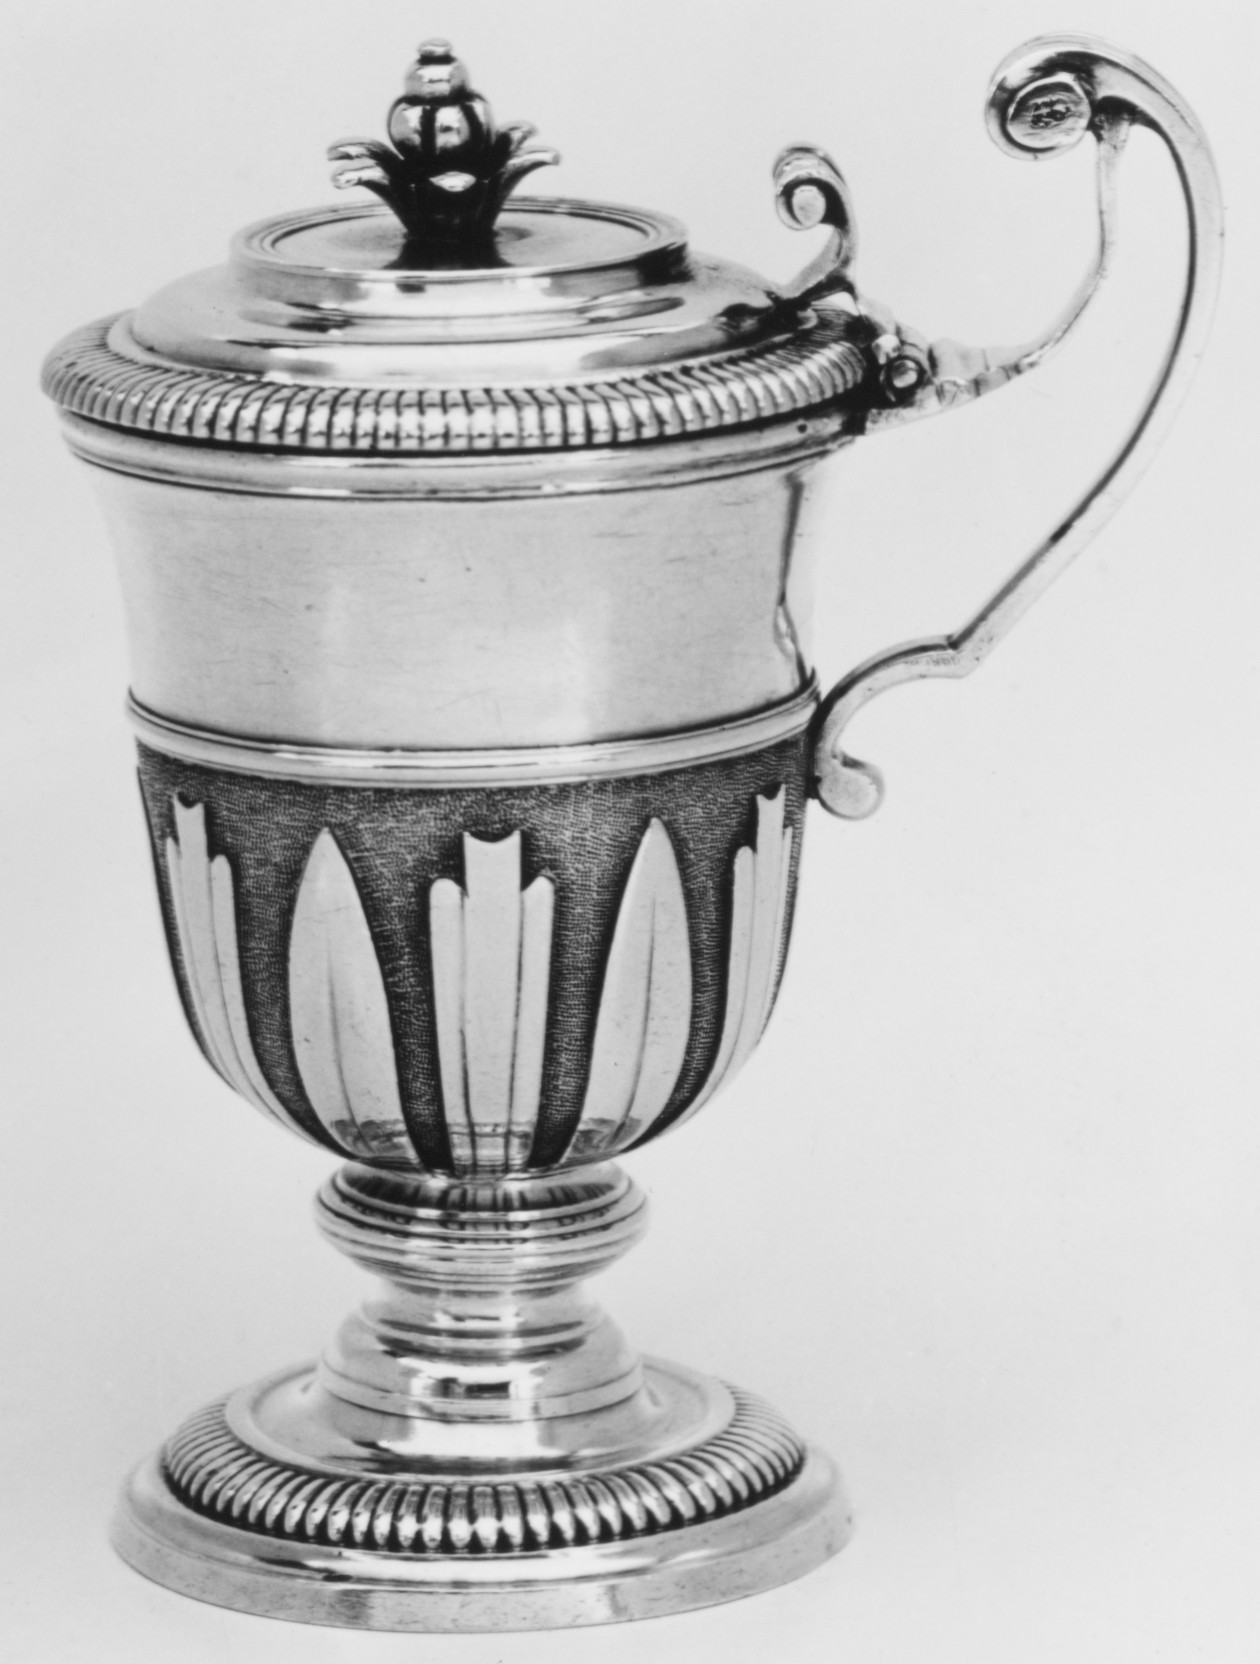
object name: mustard pot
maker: henry adnet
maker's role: maker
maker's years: 1683-1745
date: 1717-1722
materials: silver